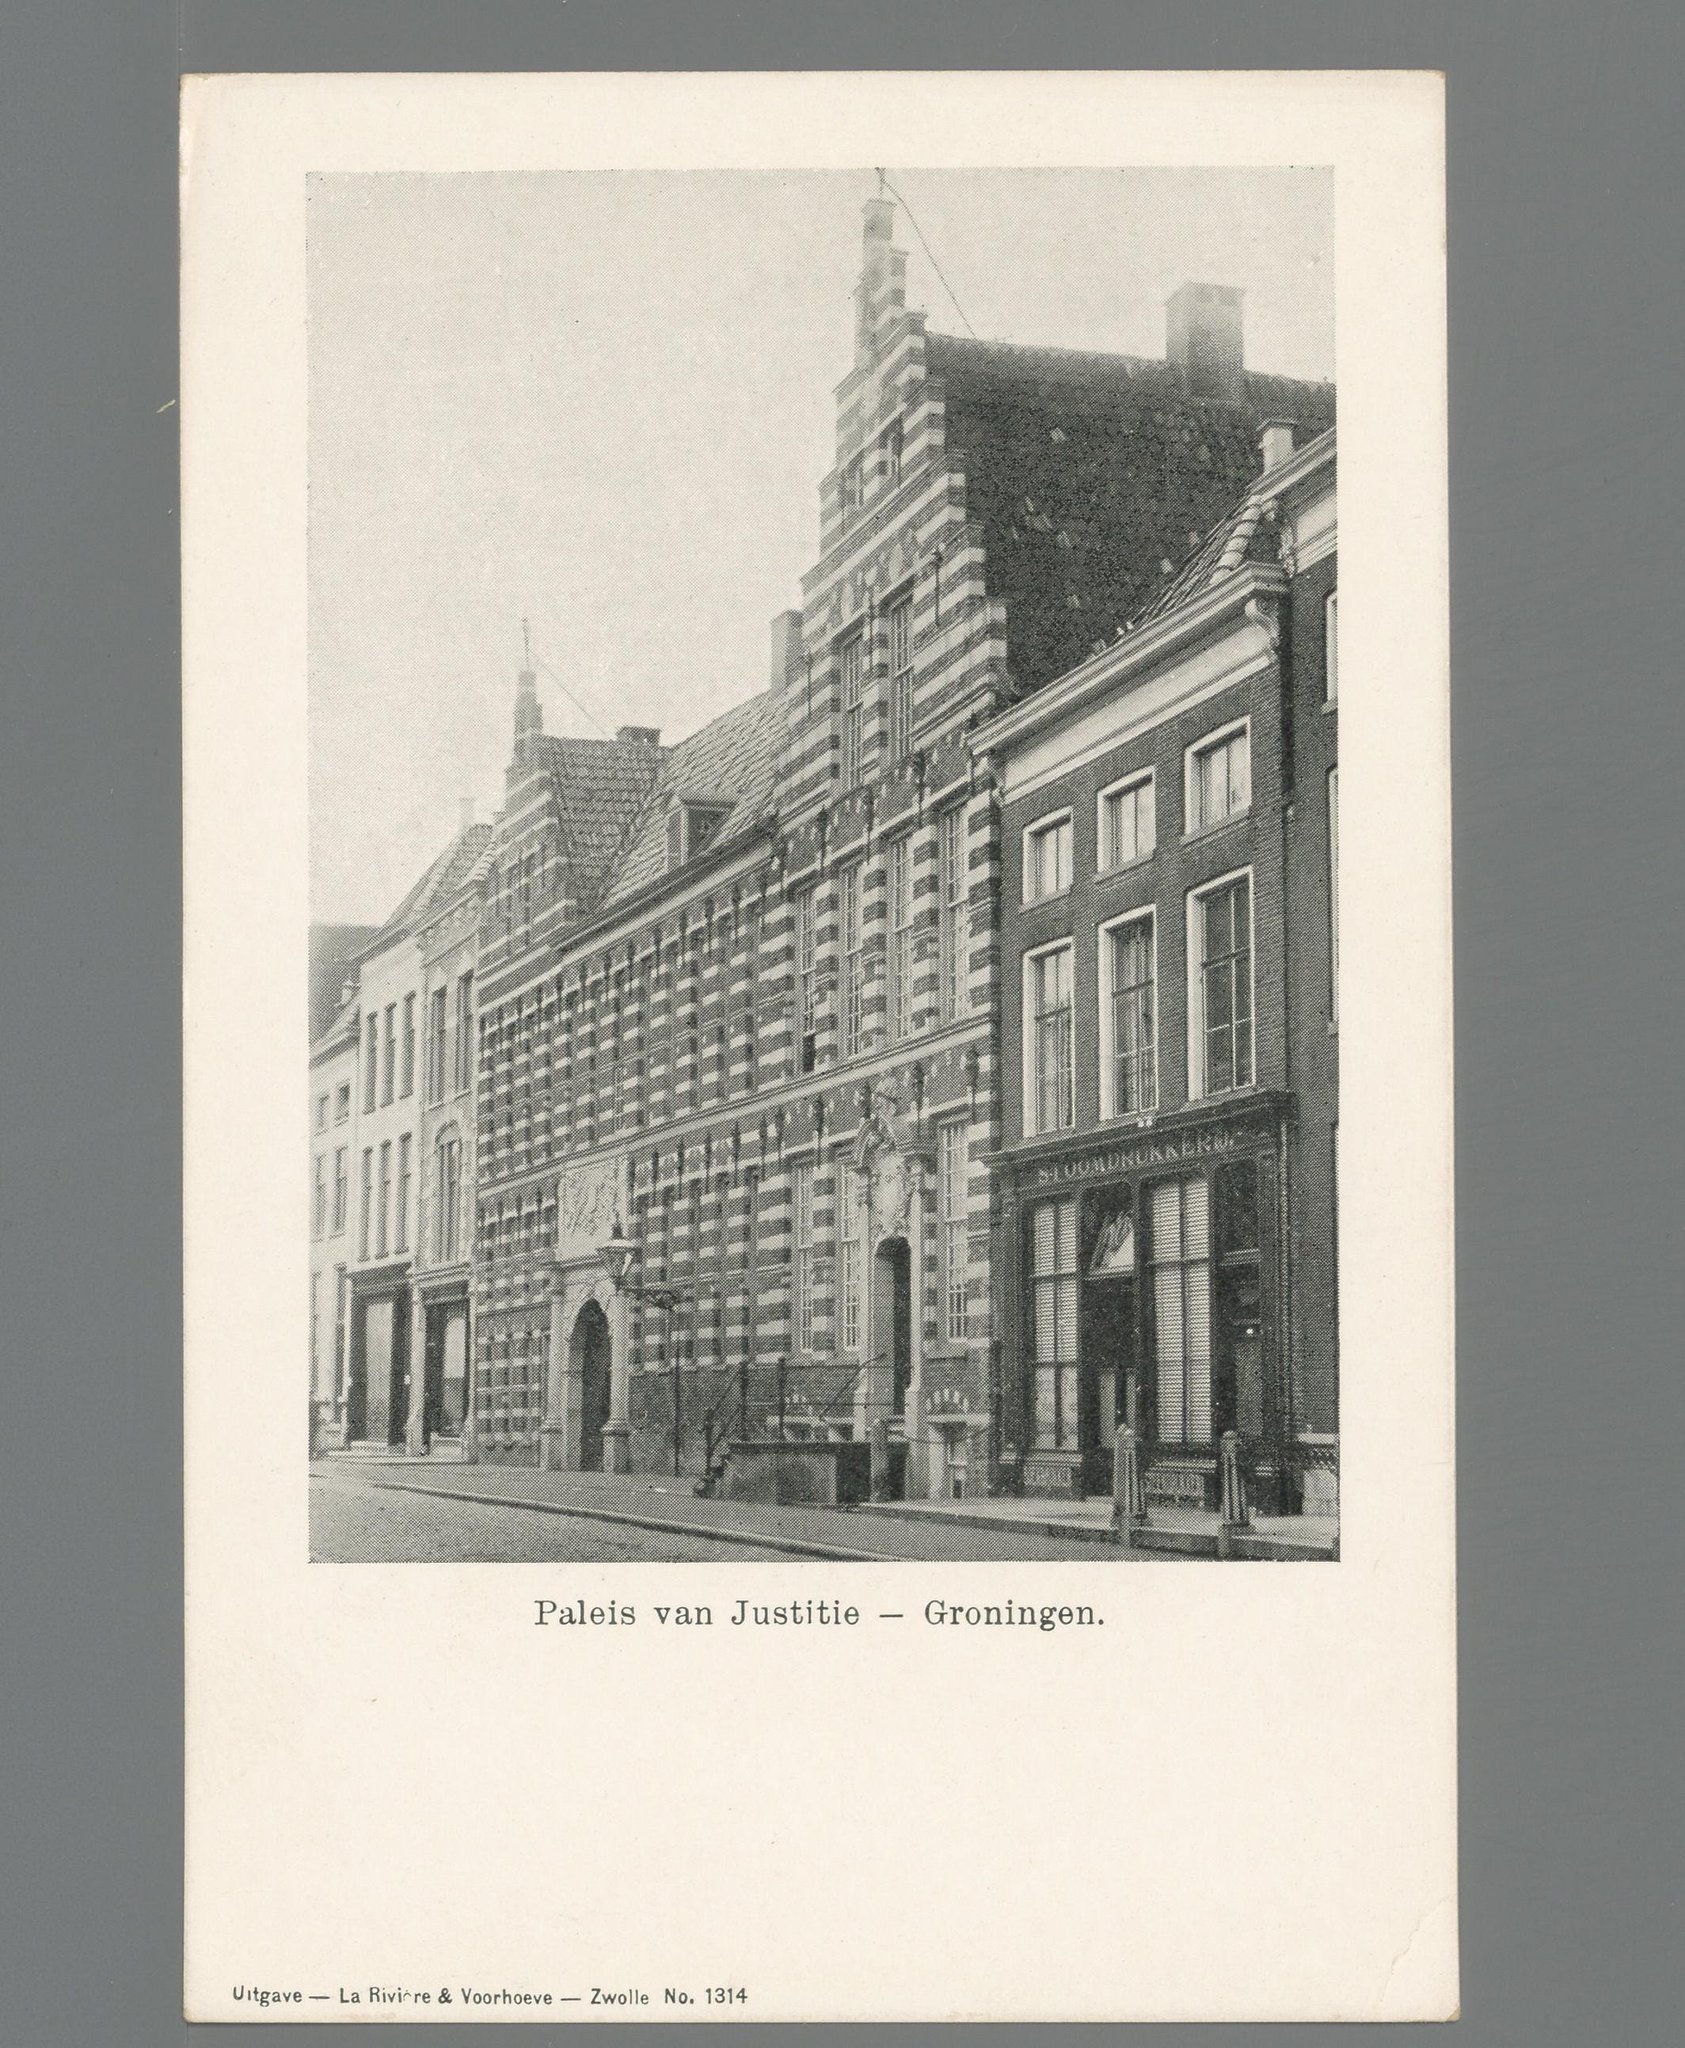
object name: photomechanical print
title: Paleis van Justitie - Groningen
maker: Anonymous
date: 1892-1905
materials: cardboard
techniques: autotype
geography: groningen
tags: court building